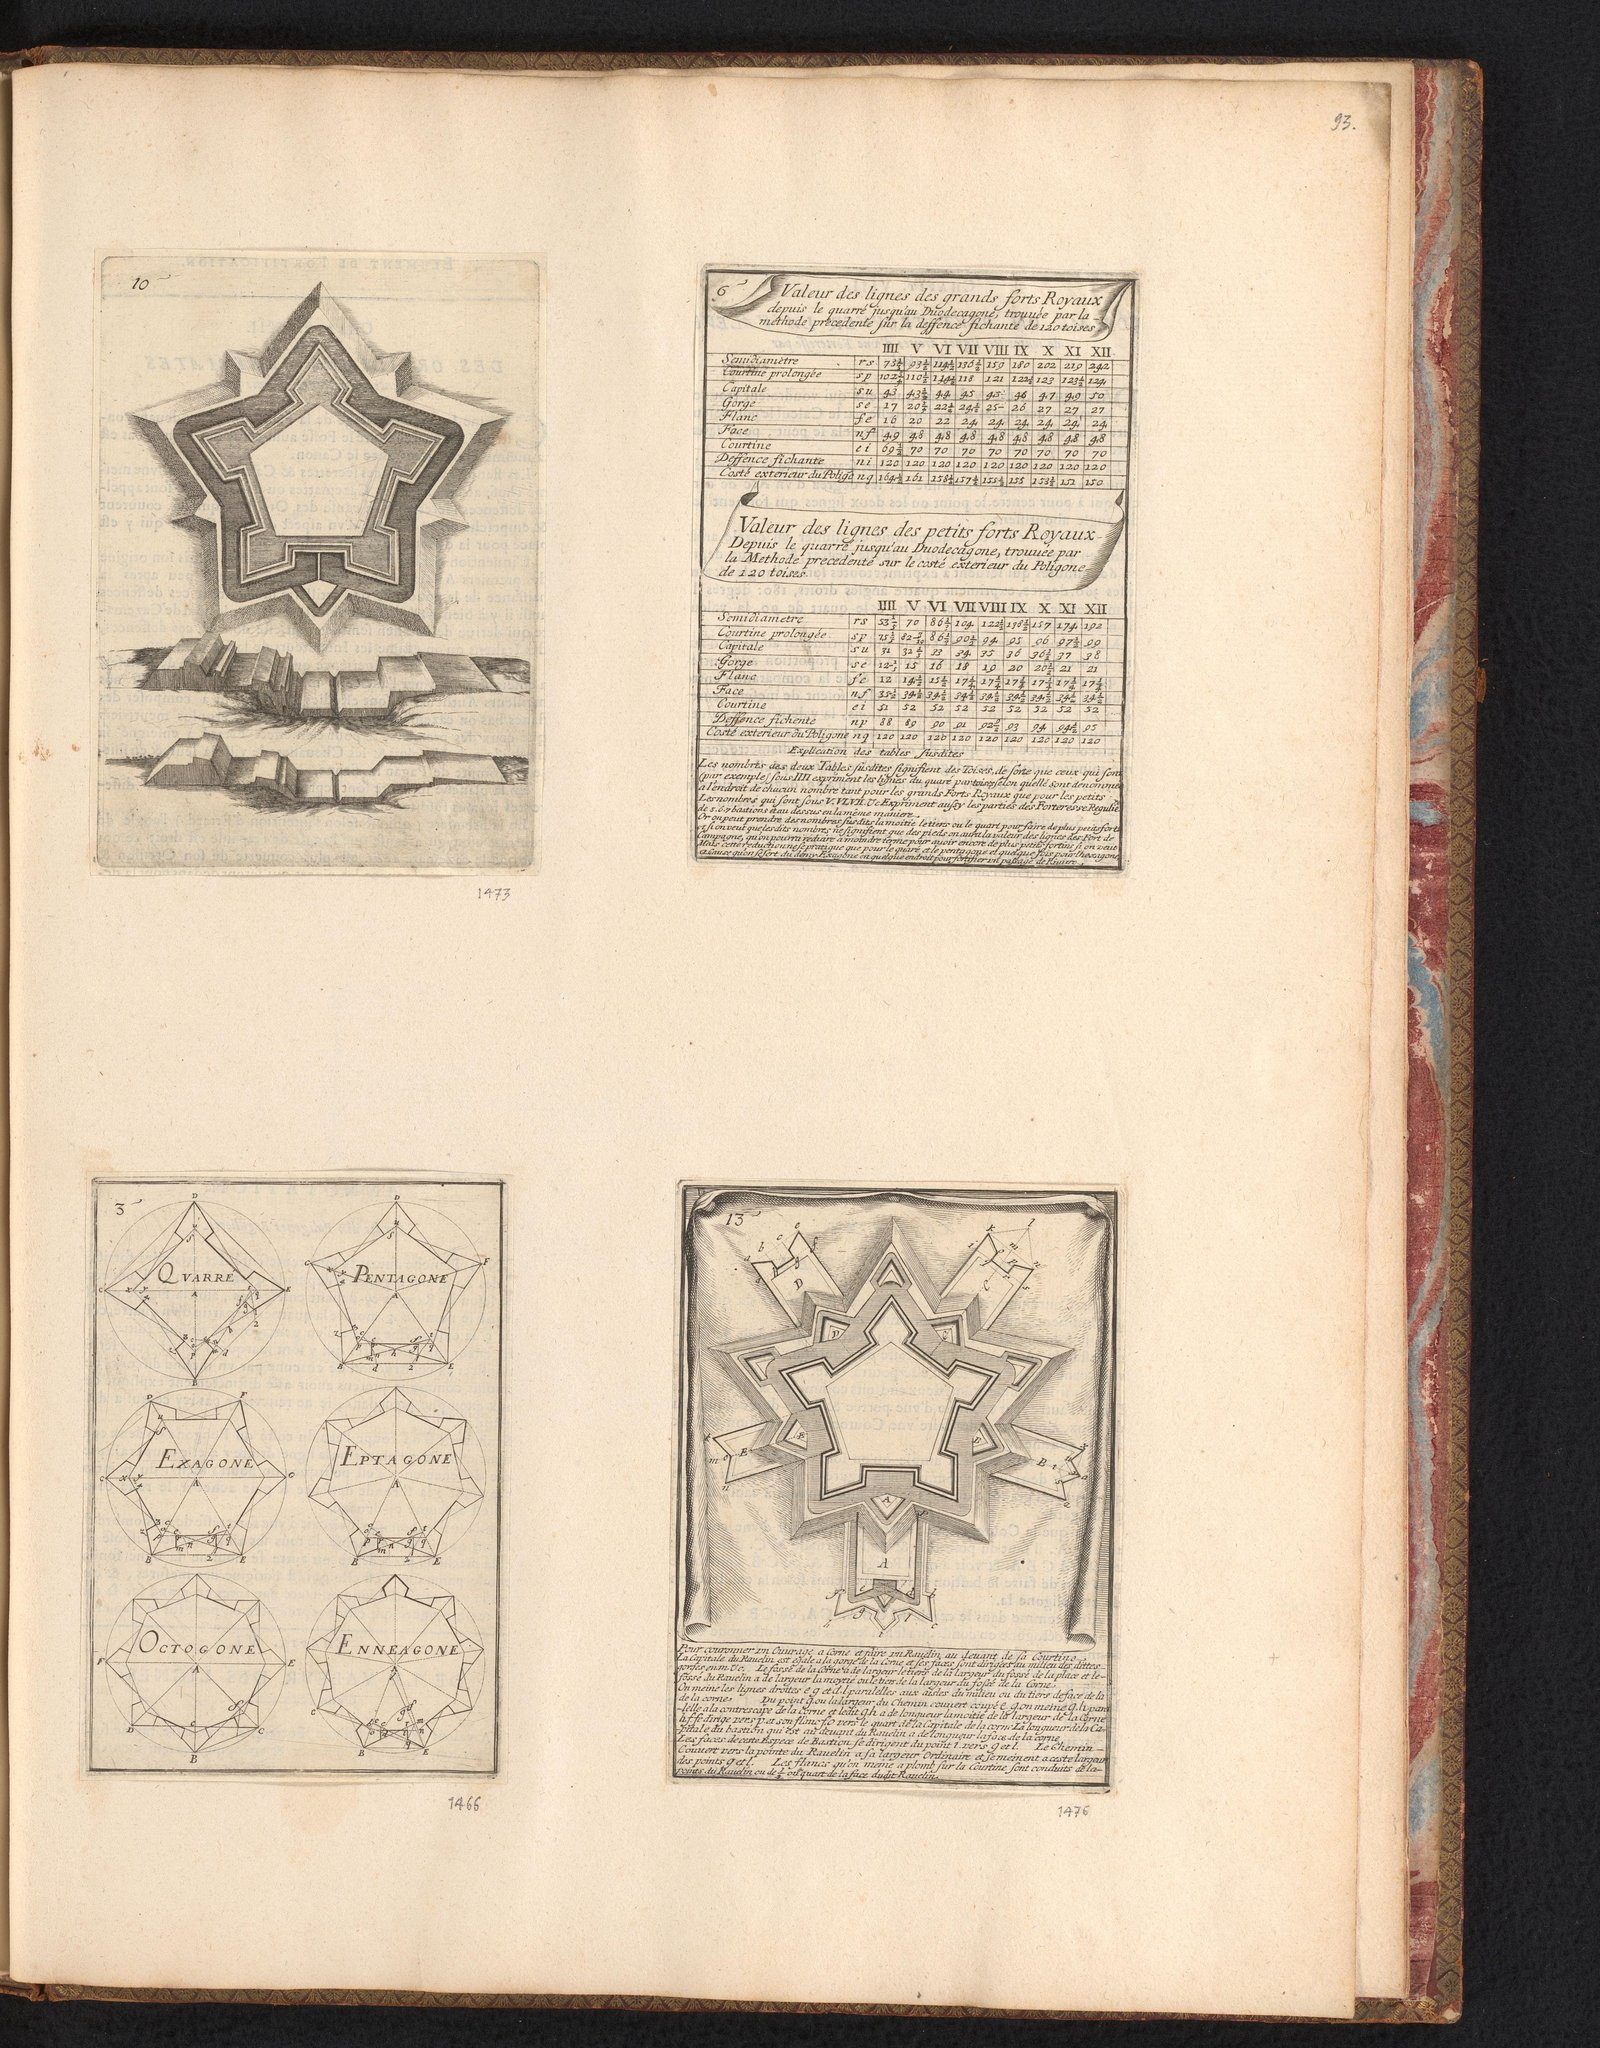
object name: album leaf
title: Plattegronden van vestingsteden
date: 1666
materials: paper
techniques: etching, letterpress printing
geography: paris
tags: fortified city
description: Twee plattegronden, een schema met zes verschillende vormen verdedigingswerken en een tabel met afmetingen. Deze vier prenten maken deel uit van een album.